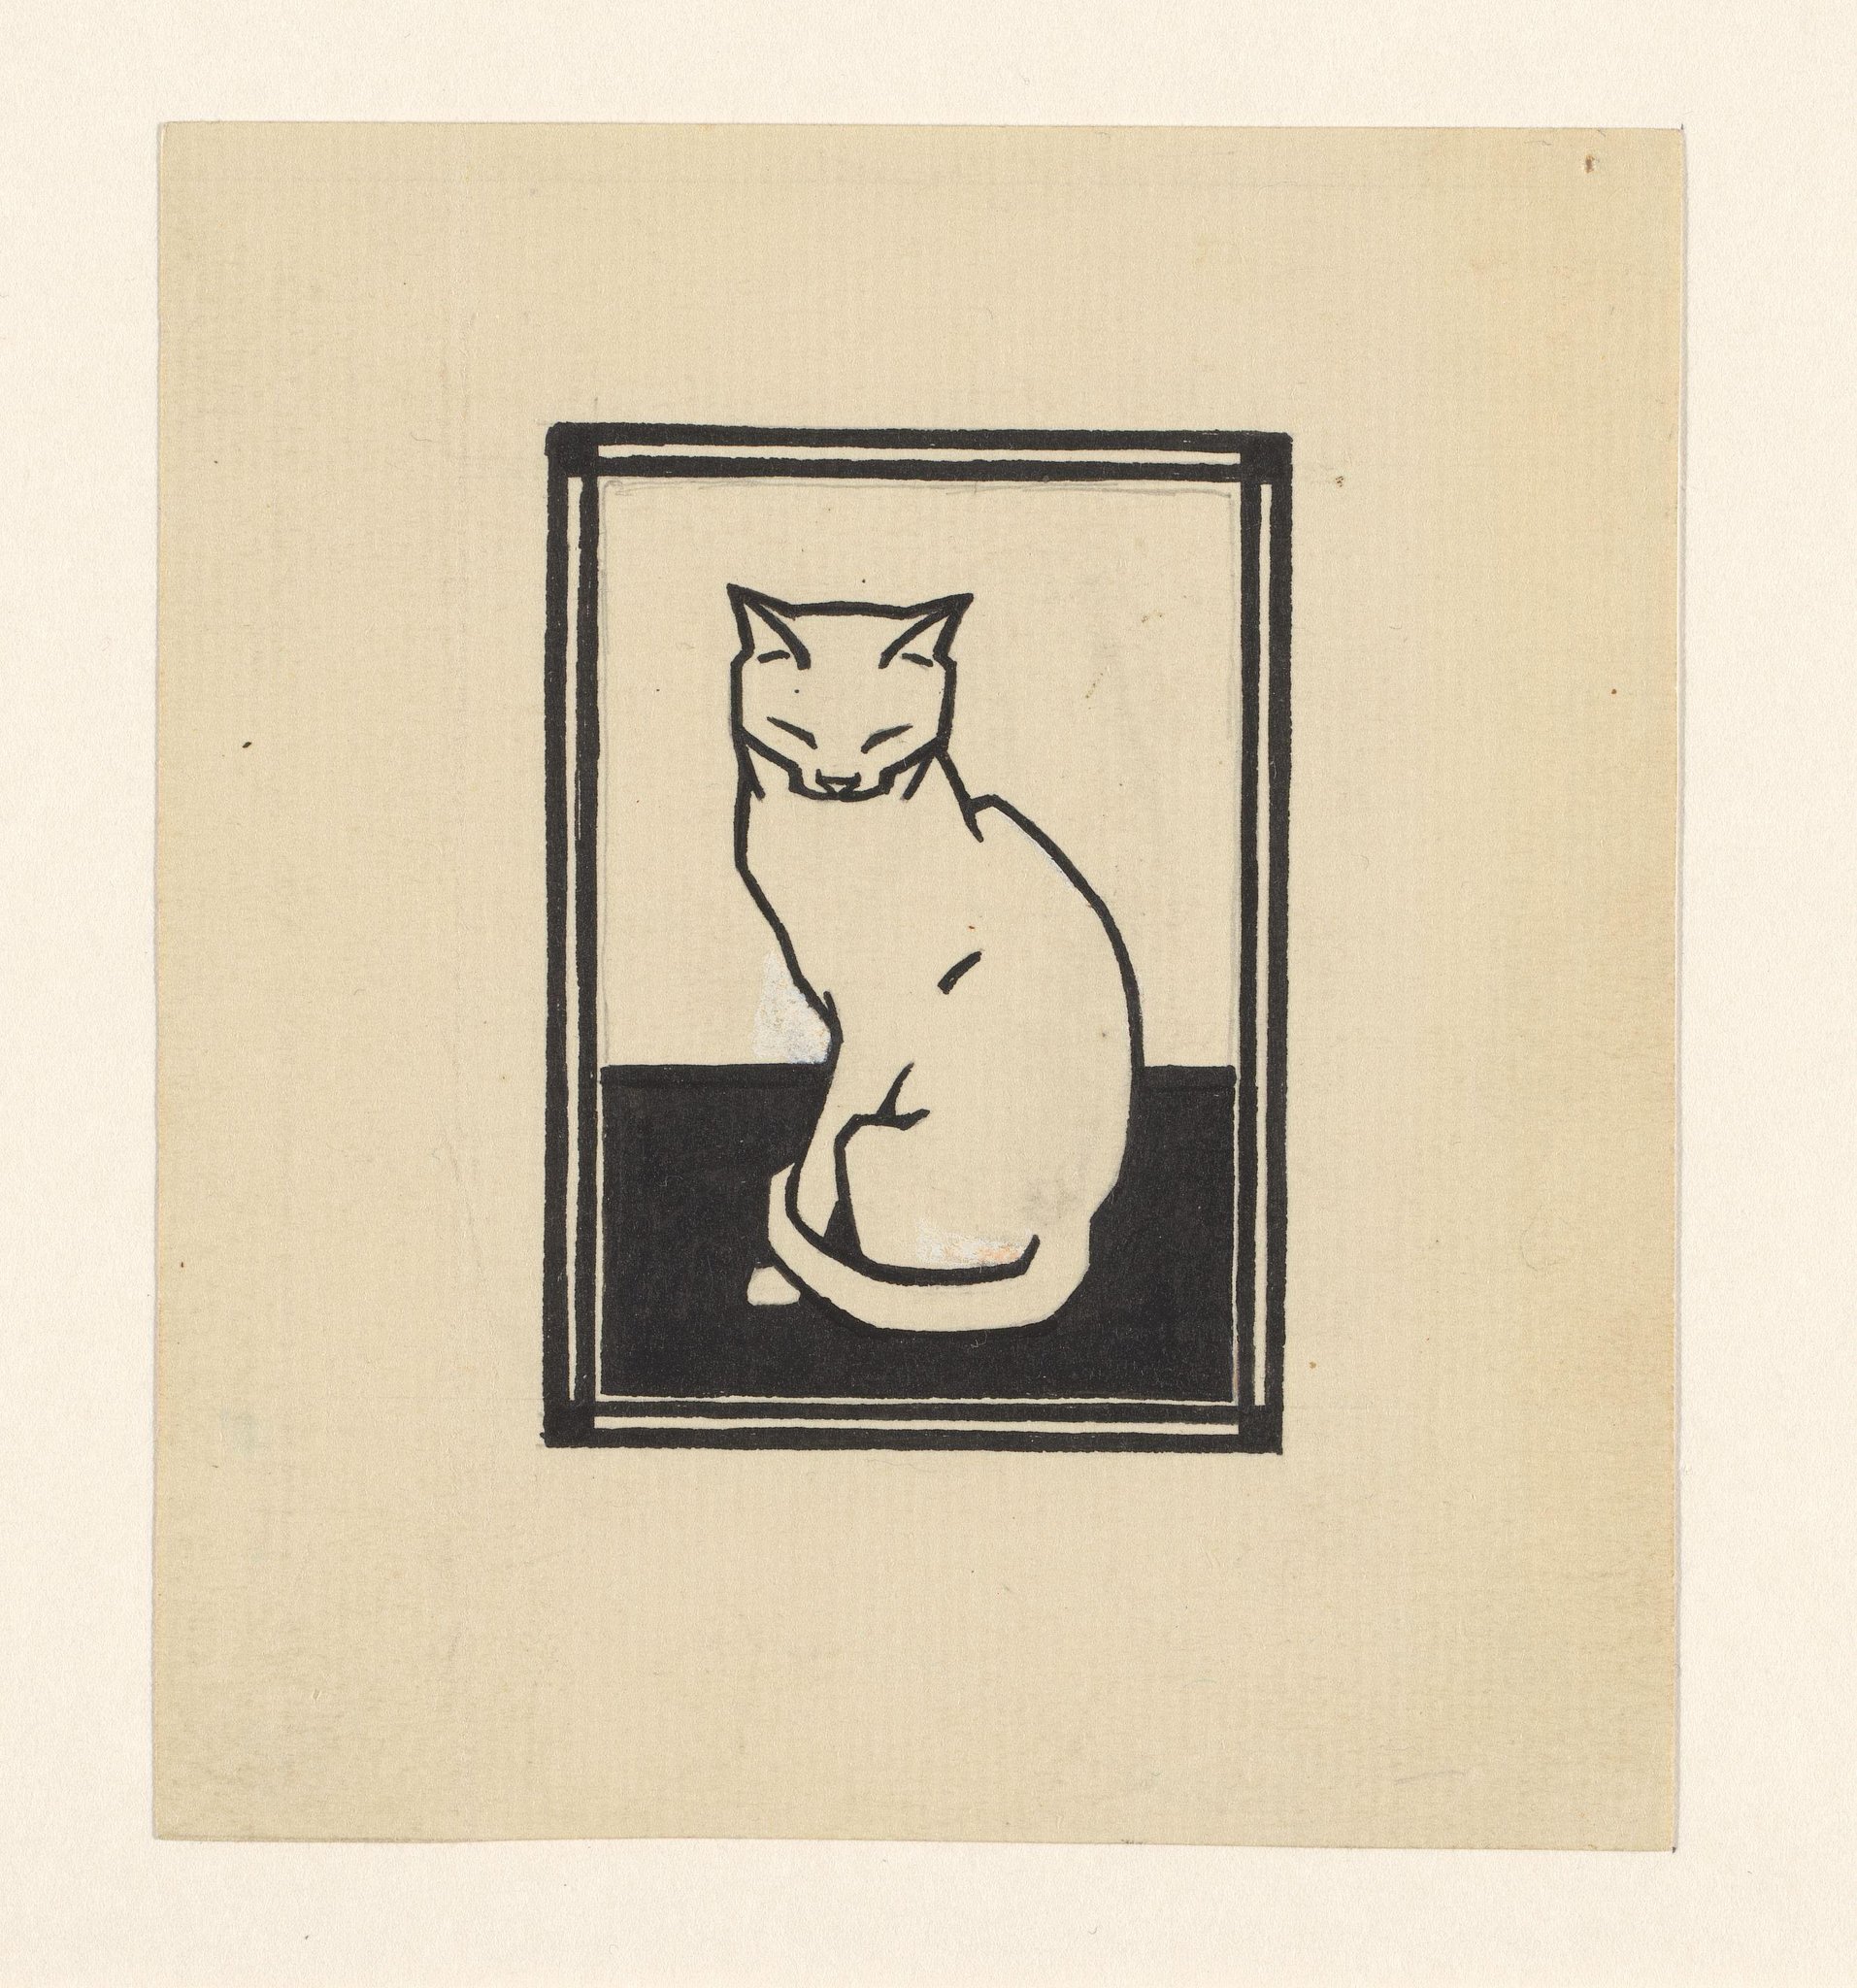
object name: drawing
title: Zittende kat met gesloten ogen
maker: julie de graag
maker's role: draughtsman, print maker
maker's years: 1877-1924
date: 1887-1924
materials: paint, ink, paper, pencil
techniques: brush, pen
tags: cat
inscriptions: annotation: ‘10-’, number: ‘39’